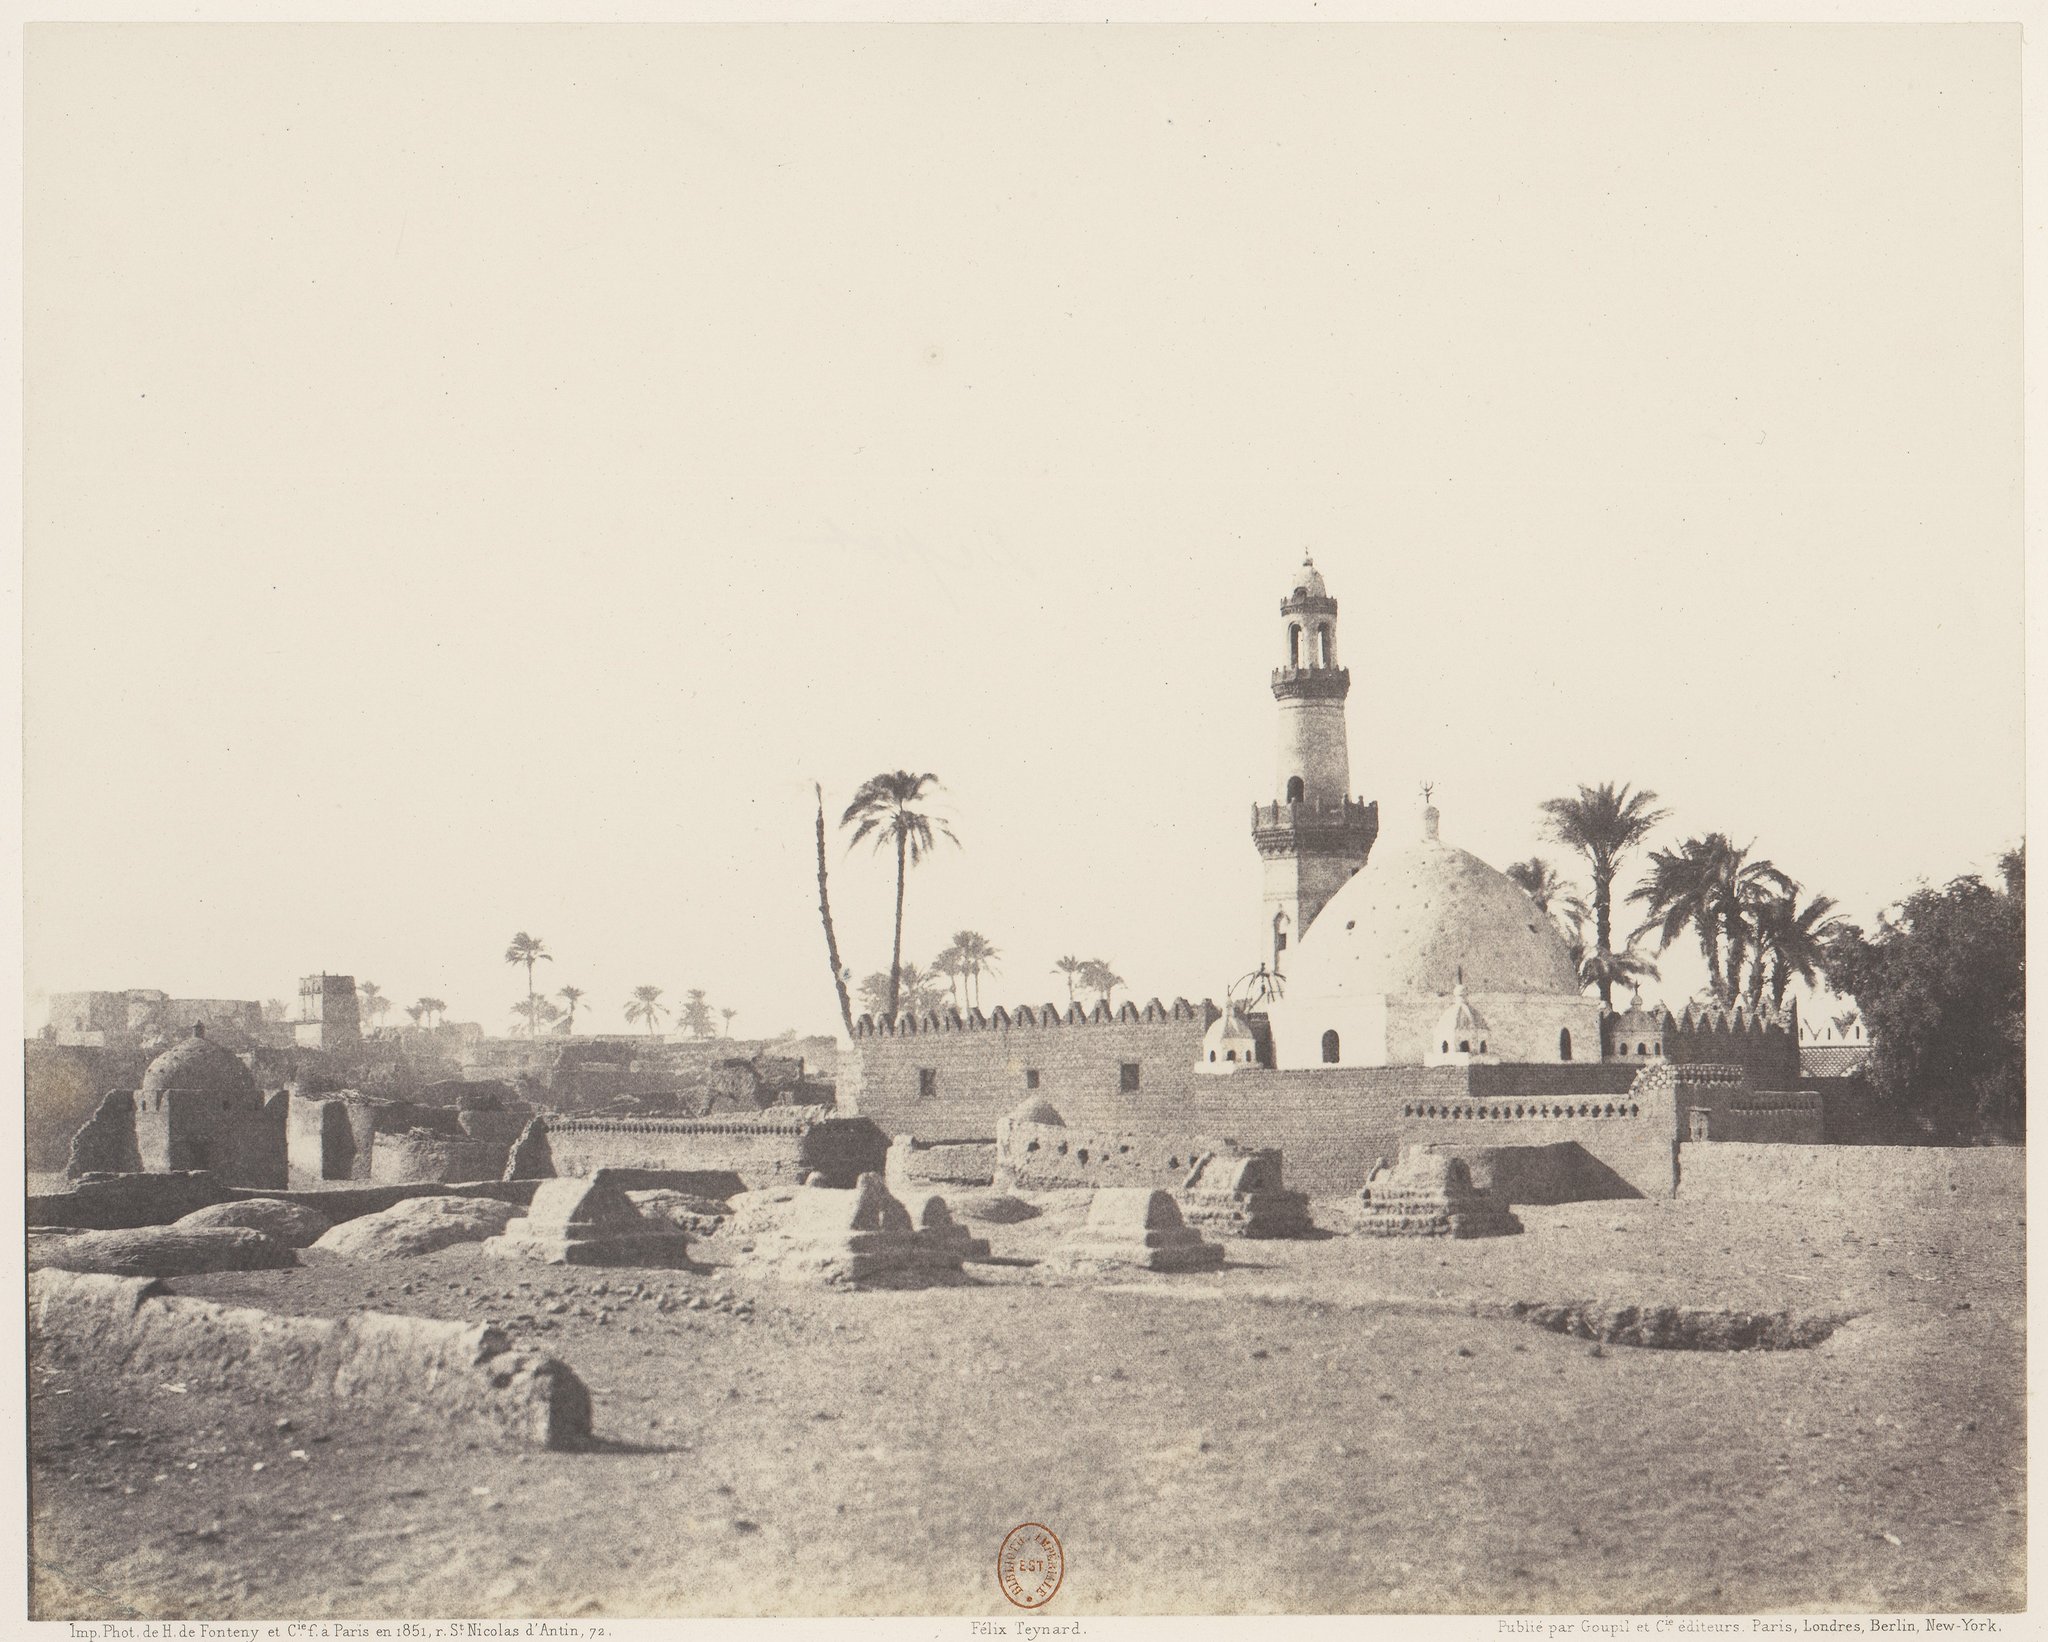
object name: photograph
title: Souâdj, Cimetière Musulman et Tombeau de Mouràd-Bey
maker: félix teynard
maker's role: artist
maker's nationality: french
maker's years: 1817-1892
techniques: paper negative, salted paper print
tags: architecture,tombs